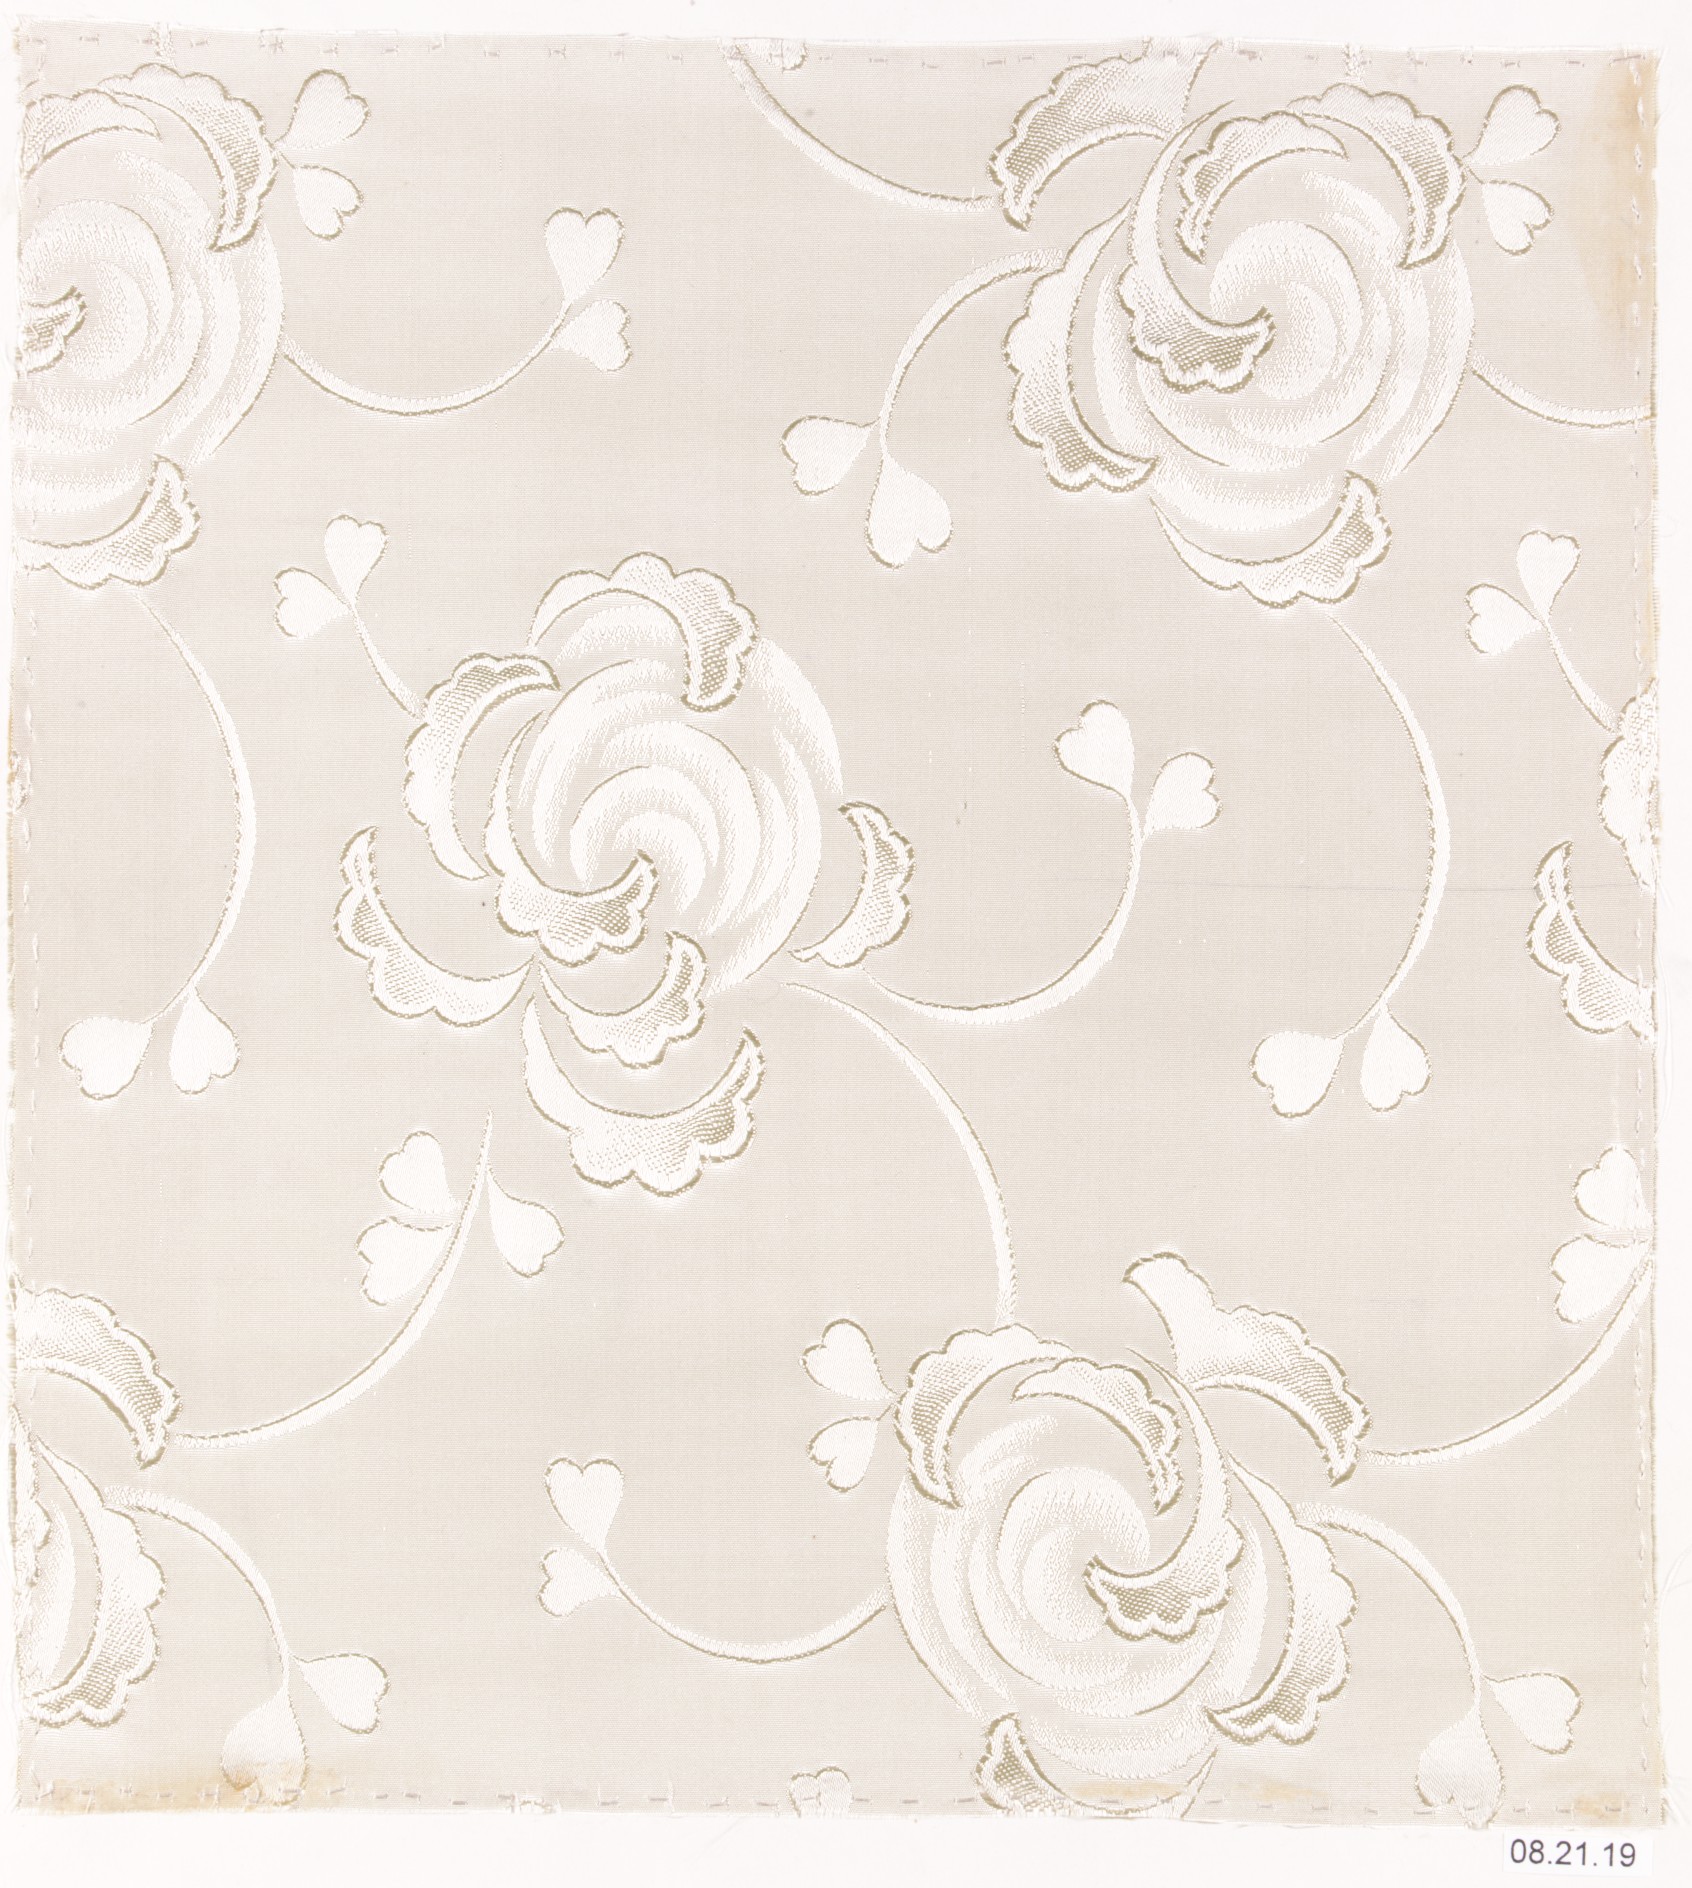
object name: textile sample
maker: Anonymous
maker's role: designer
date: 1900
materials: silk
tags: flowers